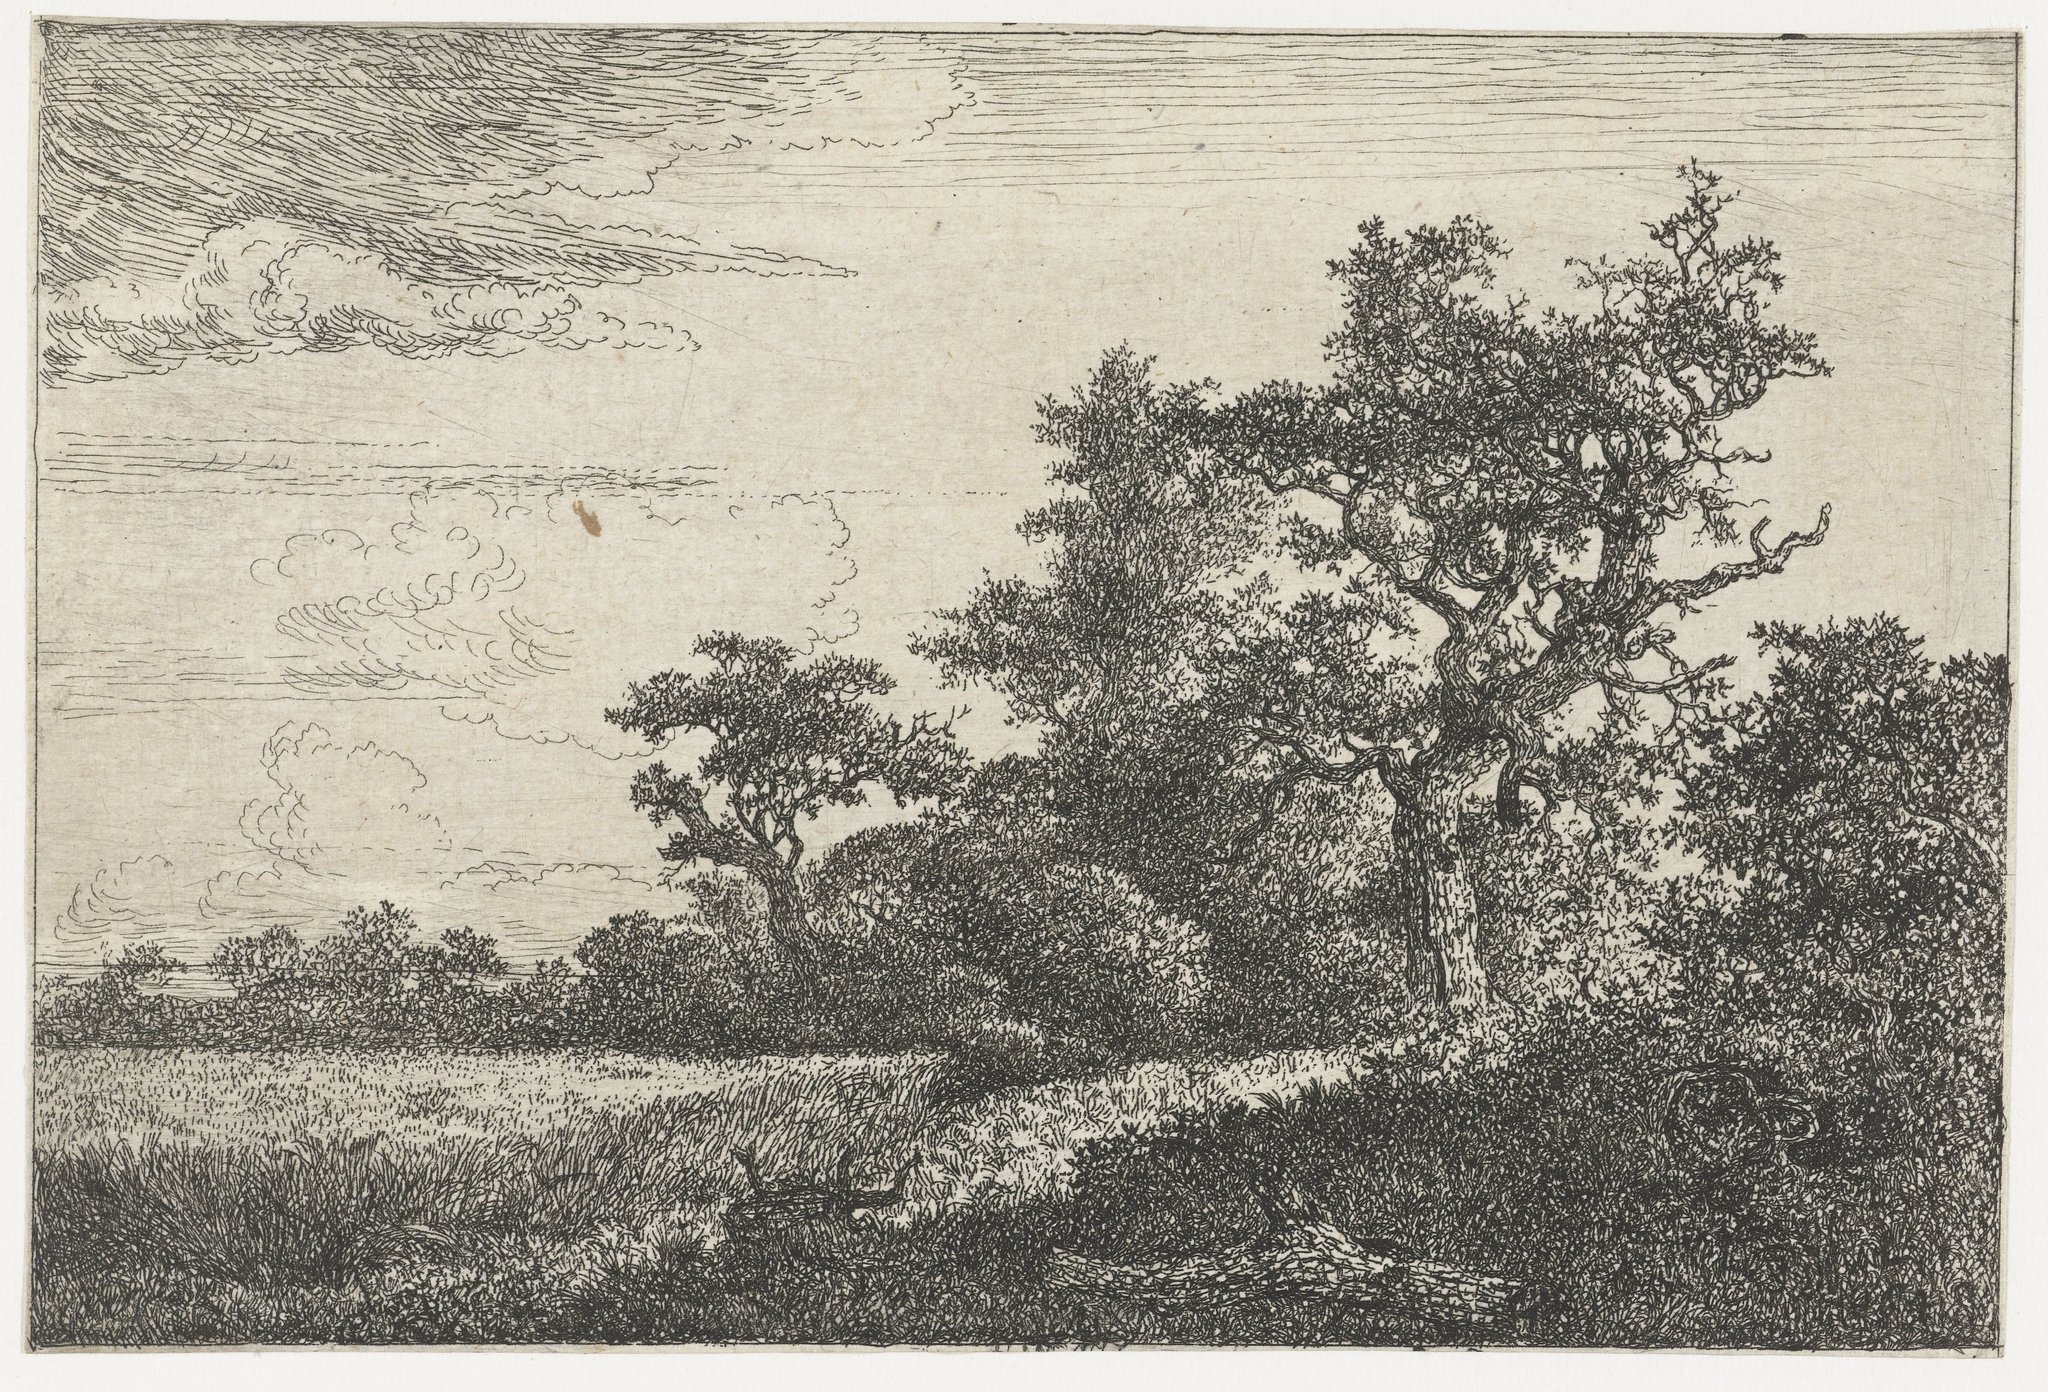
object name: print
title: Het korenveld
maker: jacob isaacksz van ruisdael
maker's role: draughtsman, painter, print maker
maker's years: 1628-1682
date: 1648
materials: paper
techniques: drypoint, etching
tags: trees, cultivated land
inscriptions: collector's mark: Lugt 2760, collector's mark: Lugt 636, collector's mark: Lugt 2228, inscription: ‘Klodepkast (?)’, collector's mark: Lugt 654, collector's mark: Lugt 533b